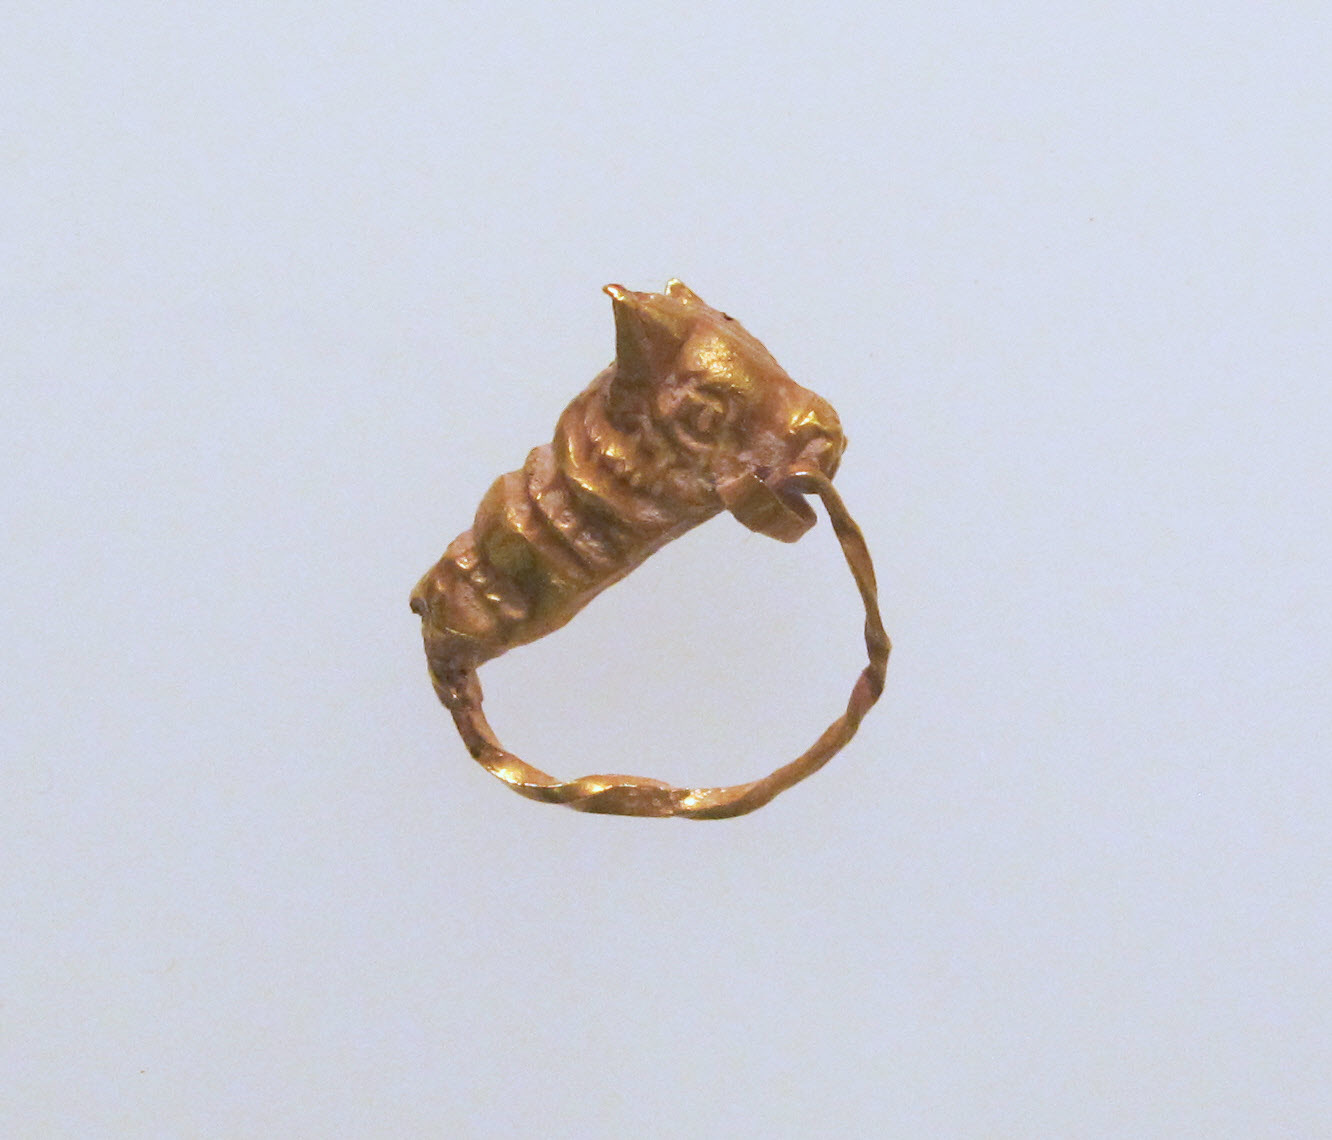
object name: earring with head of bull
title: Gold earring with head of a bull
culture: greek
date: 400-201 BCE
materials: gold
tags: bulls